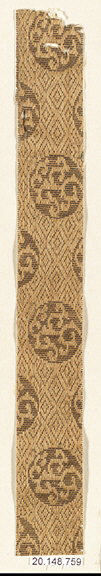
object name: piece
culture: japanese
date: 1601-1700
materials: silk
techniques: compound weave